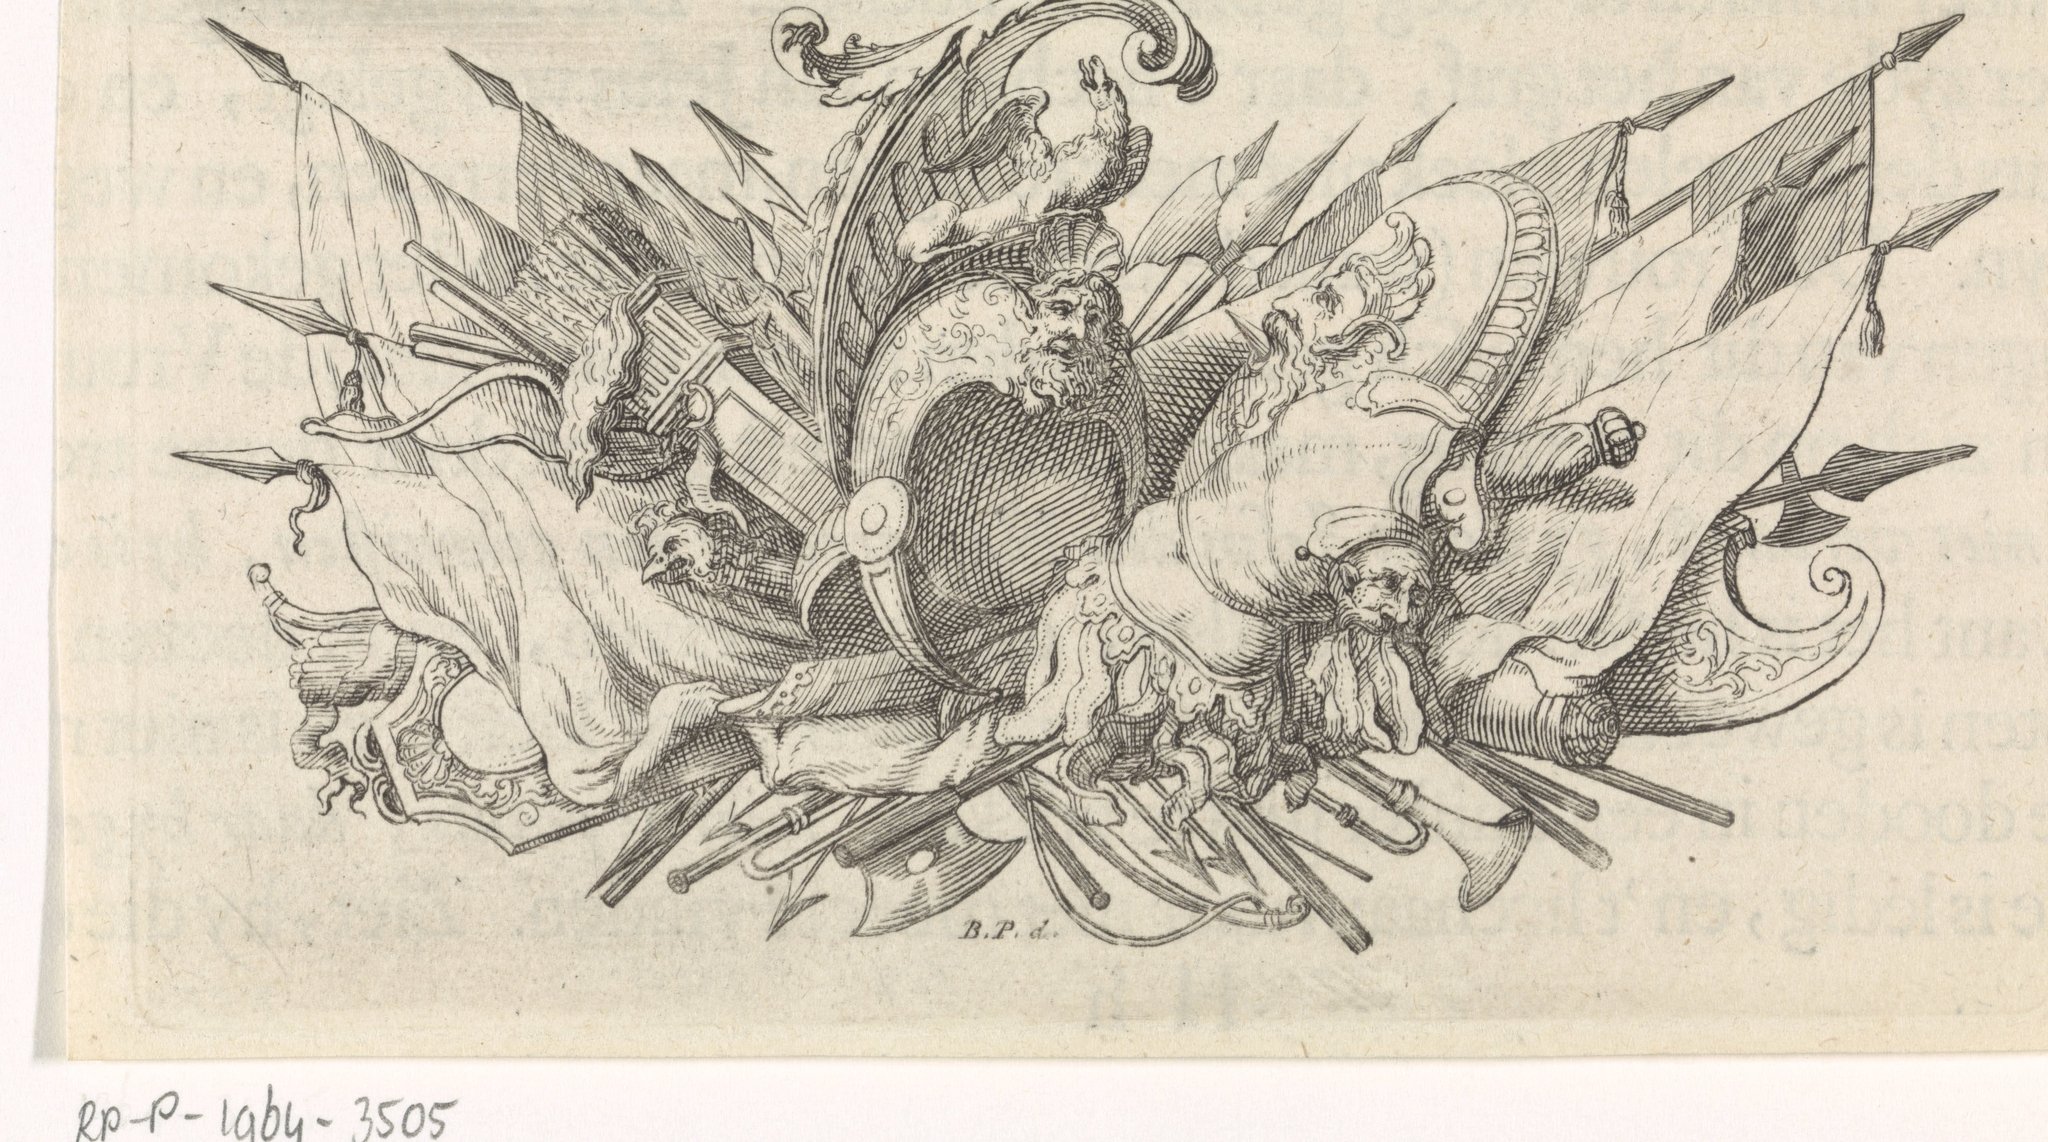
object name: print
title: Wapentrofee met vlaggen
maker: bernard picart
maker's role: draughtsman, print maker, publisher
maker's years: 1673-1733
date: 1683-1733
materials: paper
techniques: engraving, etching, letterpress printing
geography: amsterdam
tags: 'tropaion', i.e. decorative ornament ~ weapons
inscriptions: collector's mark: Lugt 2228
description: Prent oorspronkelijk bedoeld voor: Figures de la Bible. Amsterdam, Bernard Picart, 1720. Prent ook gebruikt in: Taferelen der voornaamste geschiedenissen van het Oude en Nieuwe Testament (...) door de vermaarde kunstenaars Hoet, Houbraken, en Picart getekent (...) en met beschrijvingen uitgebreid. Den Haag: Pieter de Hondt, 1728. Prent kan mogelijk ook zijn gebruikt in andere bijbels.